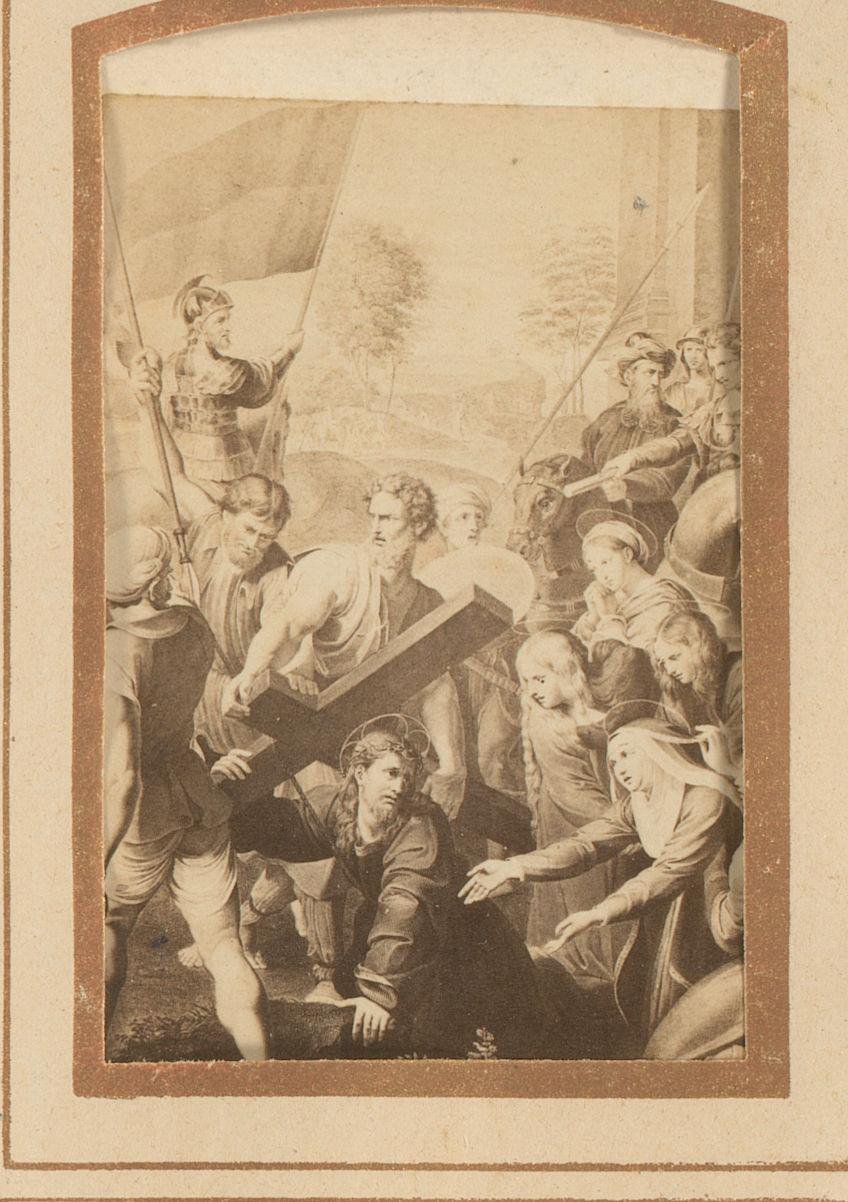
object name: album leaf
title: Fotoreproductie van de Kruisdraging door Rafaël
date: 1850-1900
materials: cardboard, photographic support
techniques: albumen print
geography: berlin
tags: christ collapsing ~ carrying of the cross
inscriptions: inscription: ‘Rafael:/ Spasimo di Sicilia./ 122./ Die Kreuztragung. - Christ bearing the cross.’, inscription: ‘Gustav Schauer/ Photographisches Kunst- und Verlags - Institut/ BERLIN/ Grosse Friedrichs - Strasse 188.’